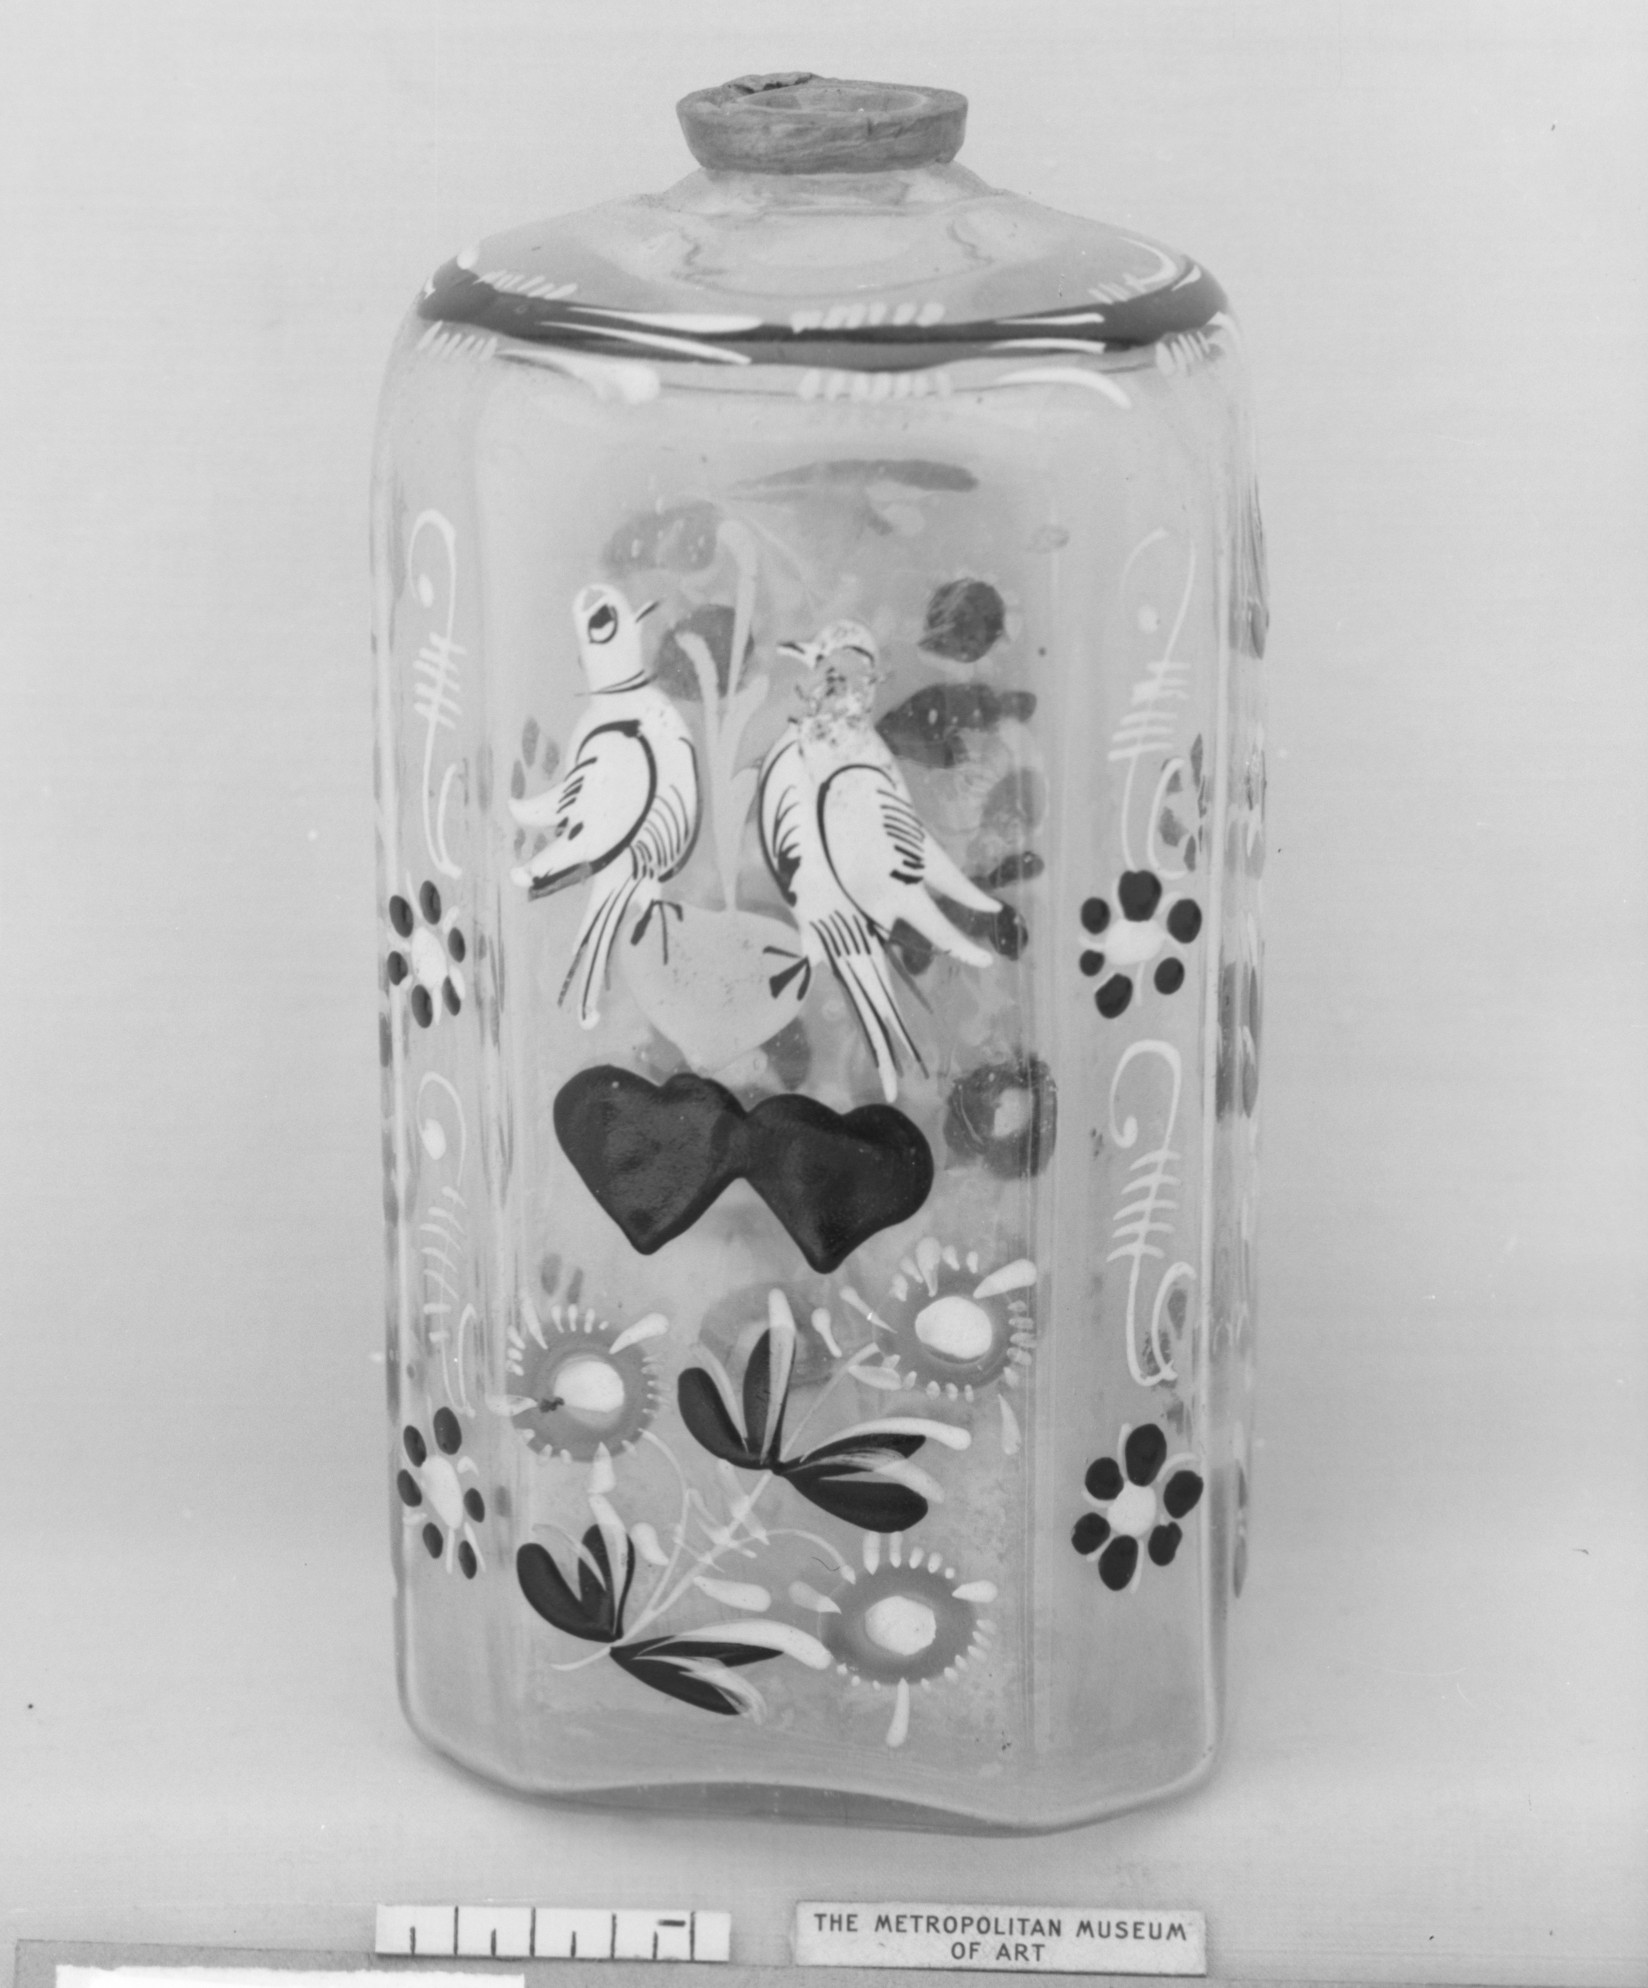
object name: bottle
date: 1701-1800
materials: glass, pewter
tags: birds